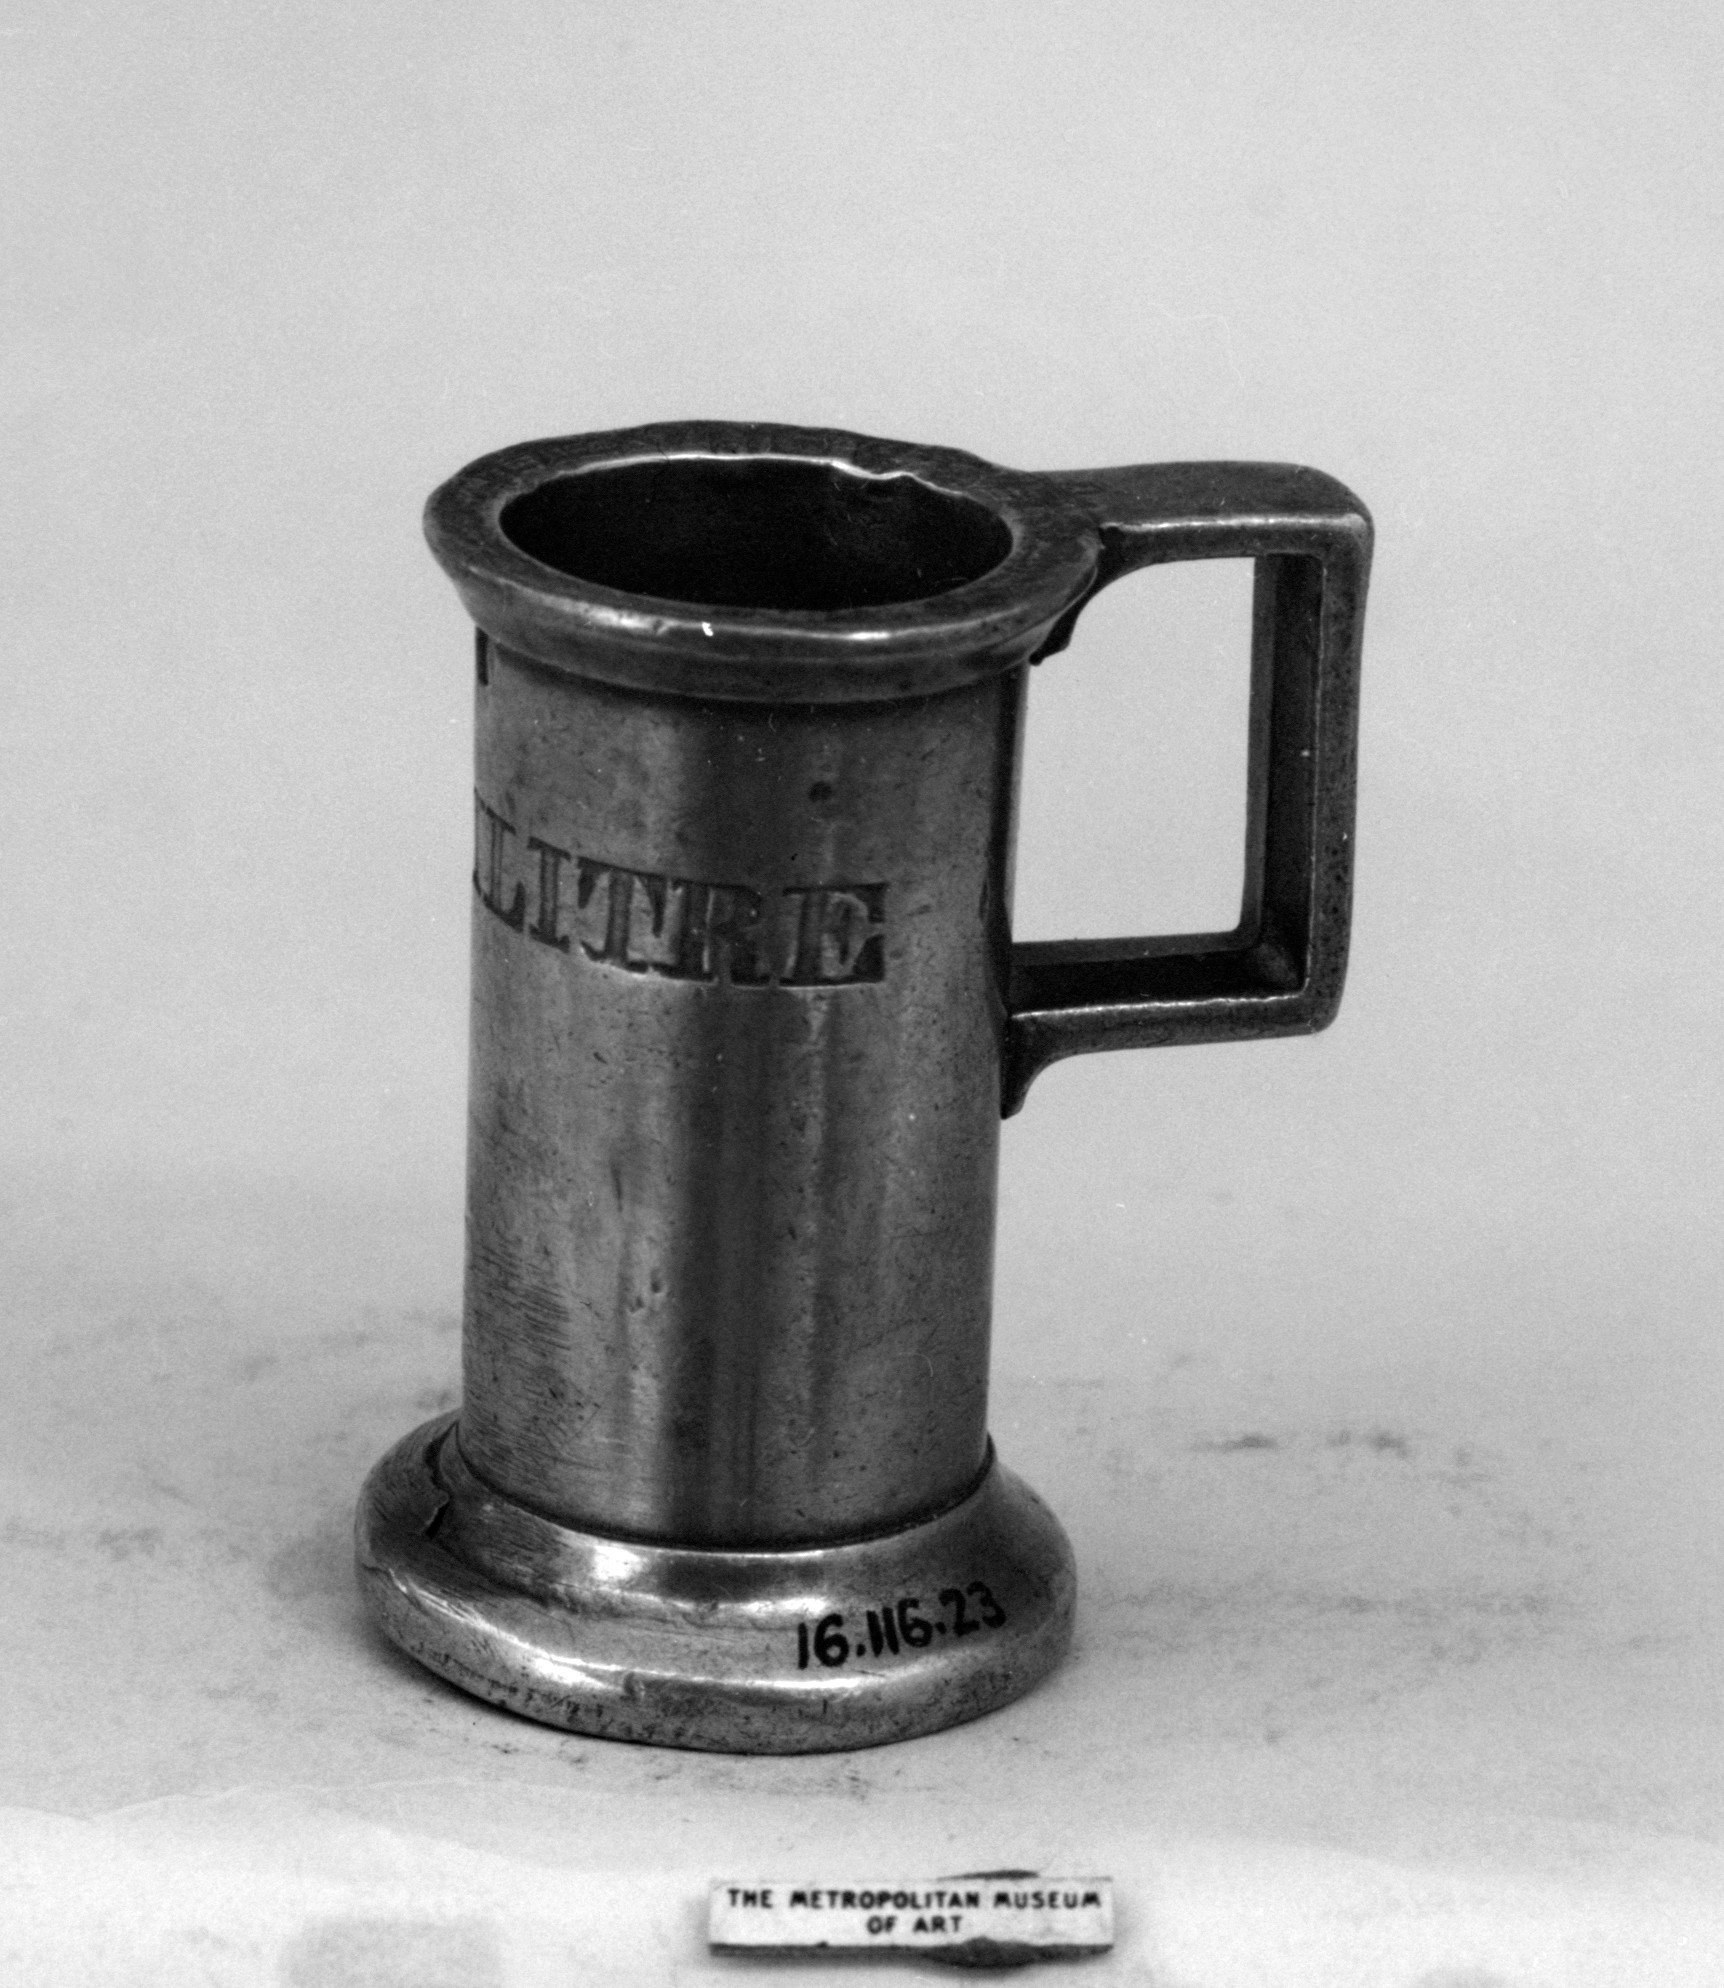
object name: measure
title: Measure (one of a set of seven)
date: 1801-1900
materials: pewter